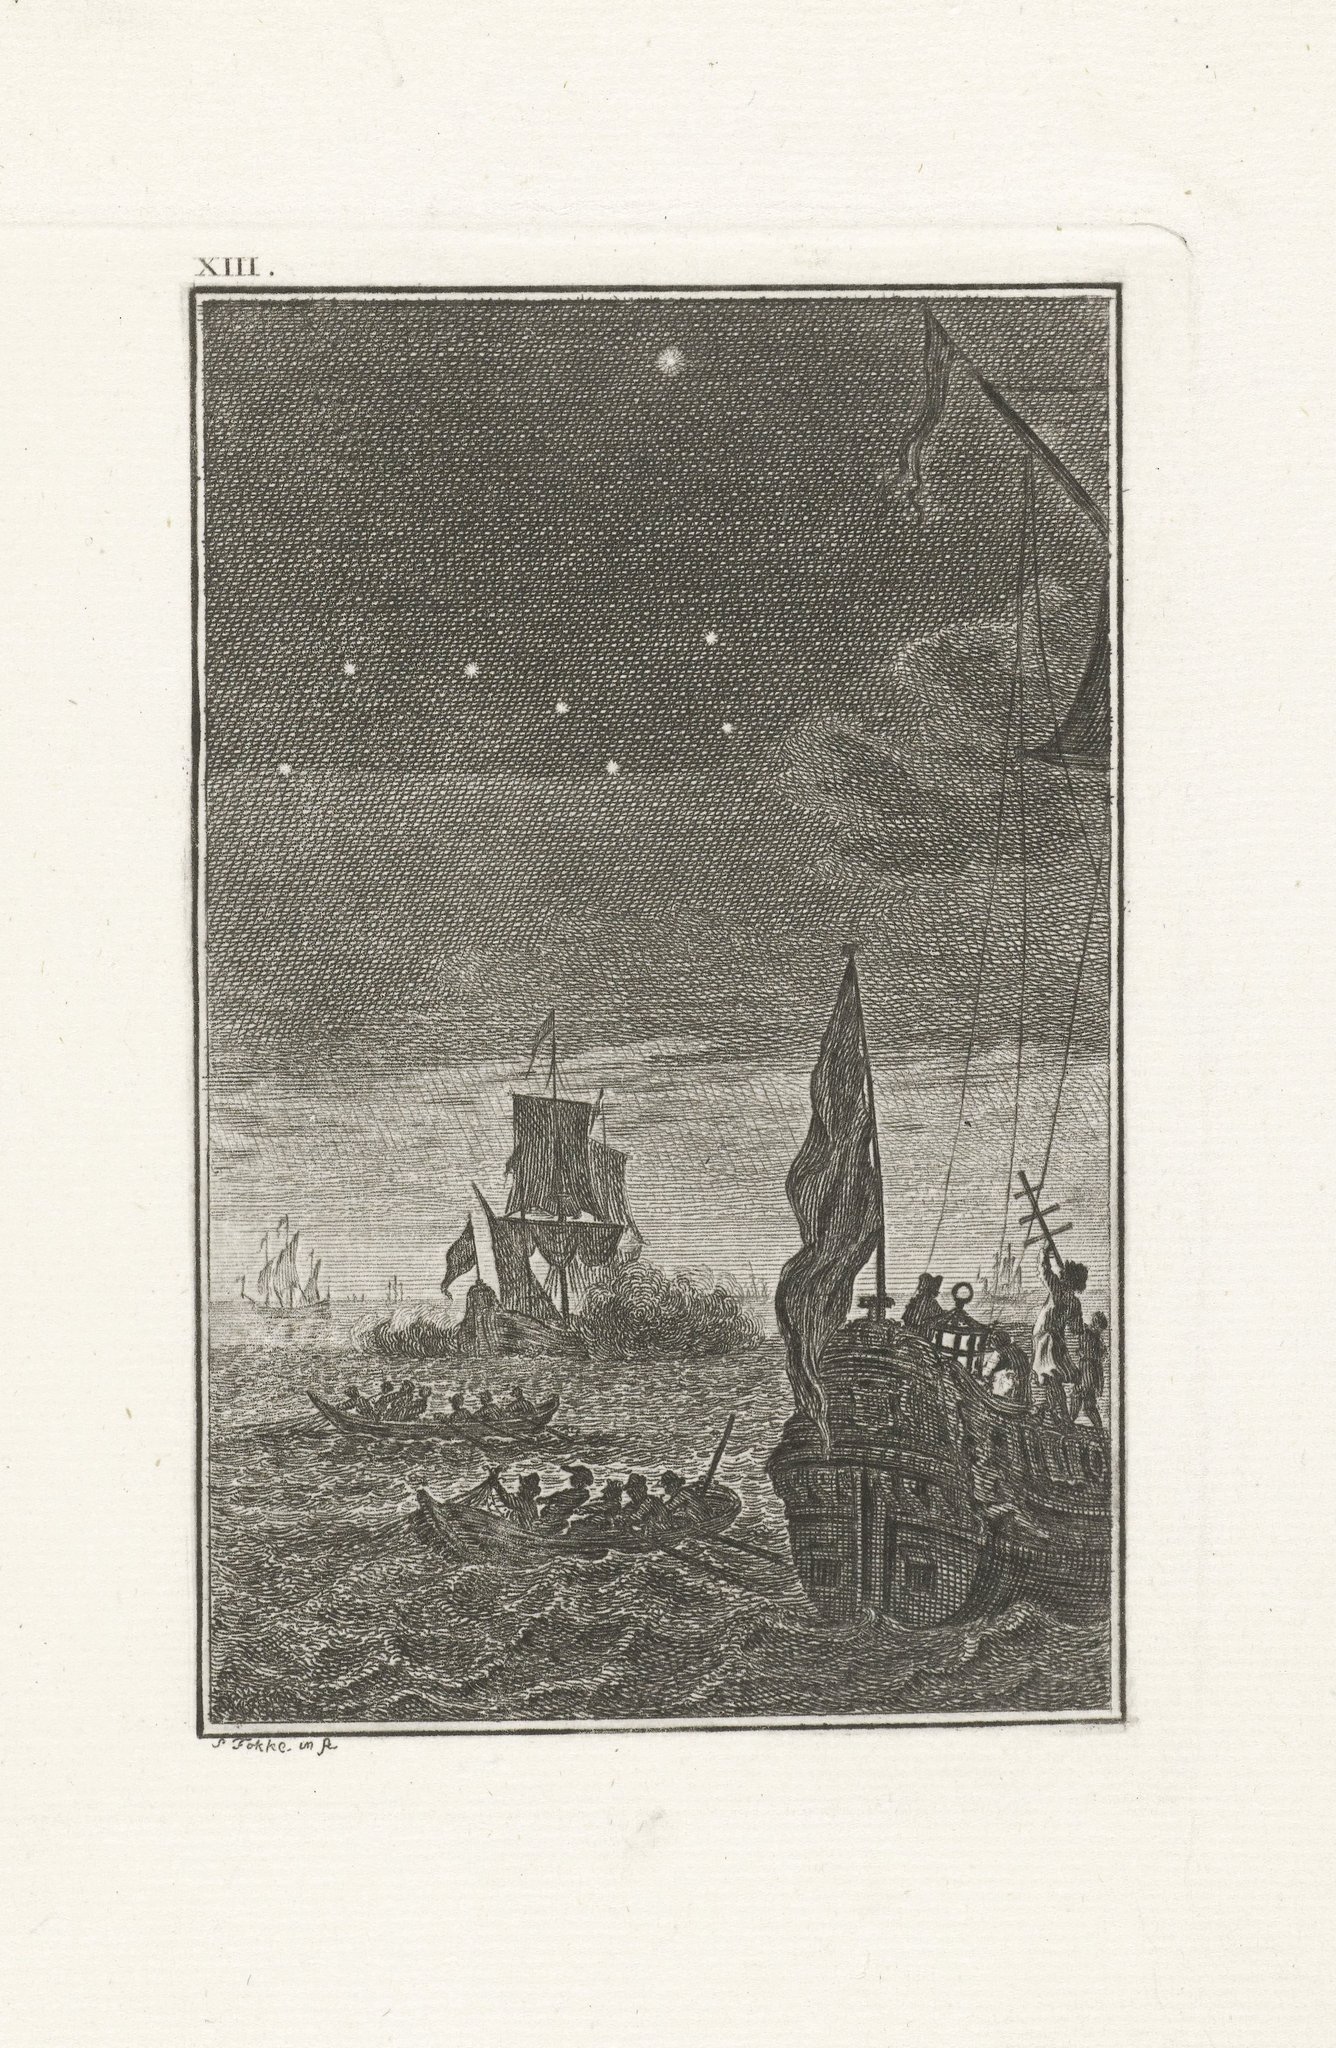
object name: book illustration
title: Zeegezicht bij nacht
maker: simon fokke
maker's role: draughtsman, print maker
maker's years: 1712-1784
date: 1722-1784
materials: paper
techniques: etching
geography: amsterdam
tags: sailing-ship, sailing-boat, rowing-boat, canoe, etc., night, gunpowder disaster (+ naval force)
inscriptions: collector's mark: Lugt 2228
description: Zeegezicht bij nacht met zeilschepen en roeiboten. In de verte vergaat een gebombardeerd schip. Prent linksboven gemerkt: XIII.